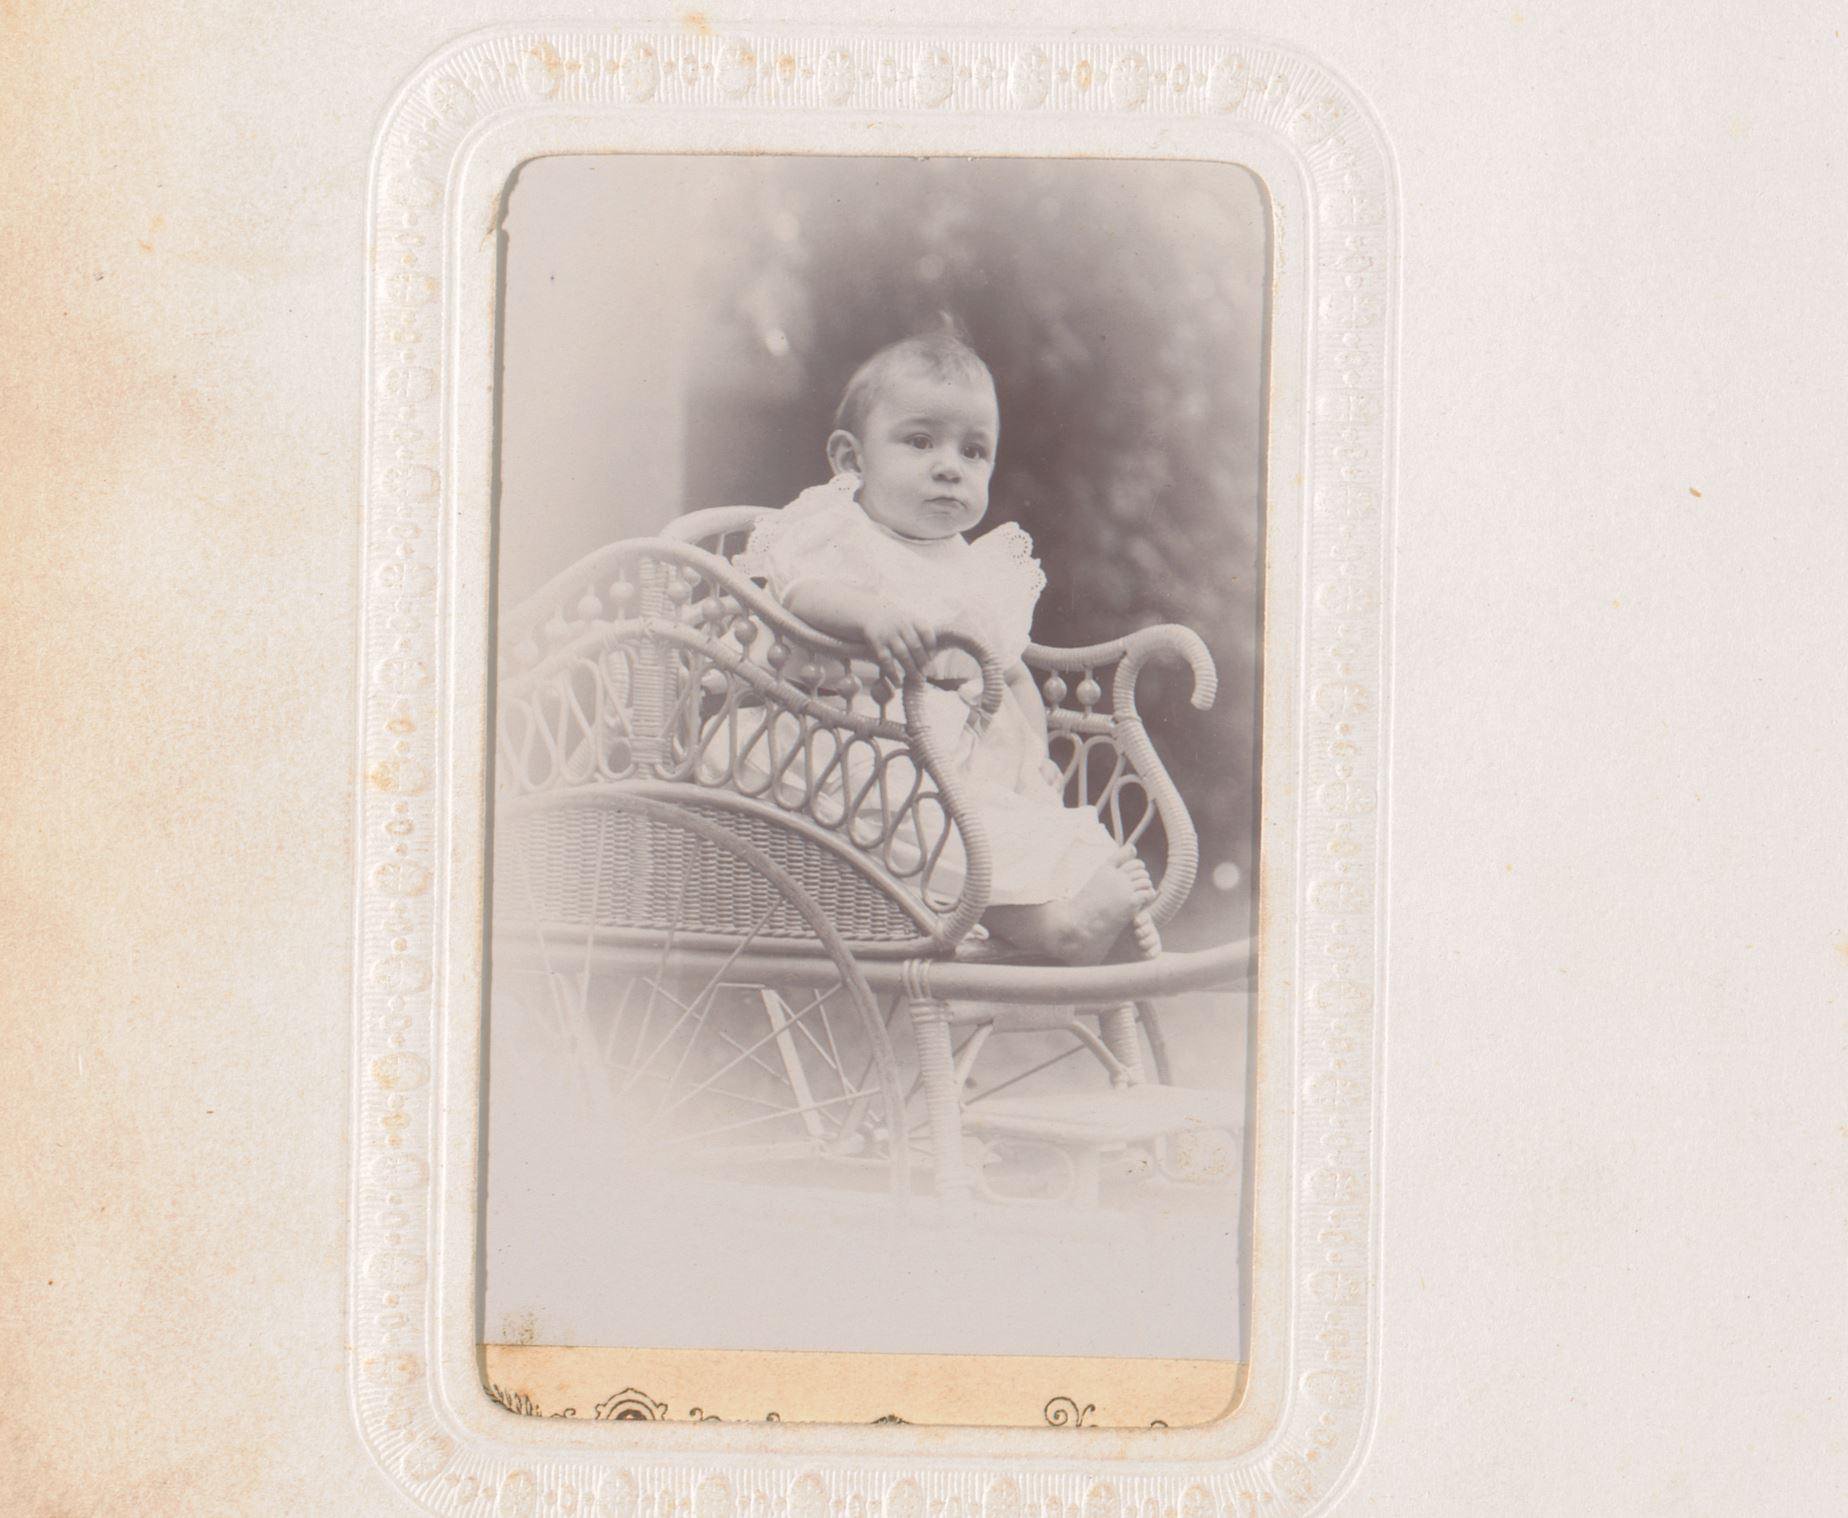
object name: carte de visite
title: Portret van een zittende baby, aangeduid als Willem Doyer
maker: jan anthonie eelsingh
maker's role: fotograaf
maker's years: 1866-1949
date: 1898-1901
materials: cardboard, photographic support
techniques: collodion silver print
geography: zwolle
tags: sitting figure, historical persons, infant, baby ~ the ages of man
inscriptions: annotation: ‘Willem/ Doyer/ 3/4 j./ Henri’, inscription: ‘J.A. EELSINGH/ Zwolle/ NIEUWE MARKT G 26.’